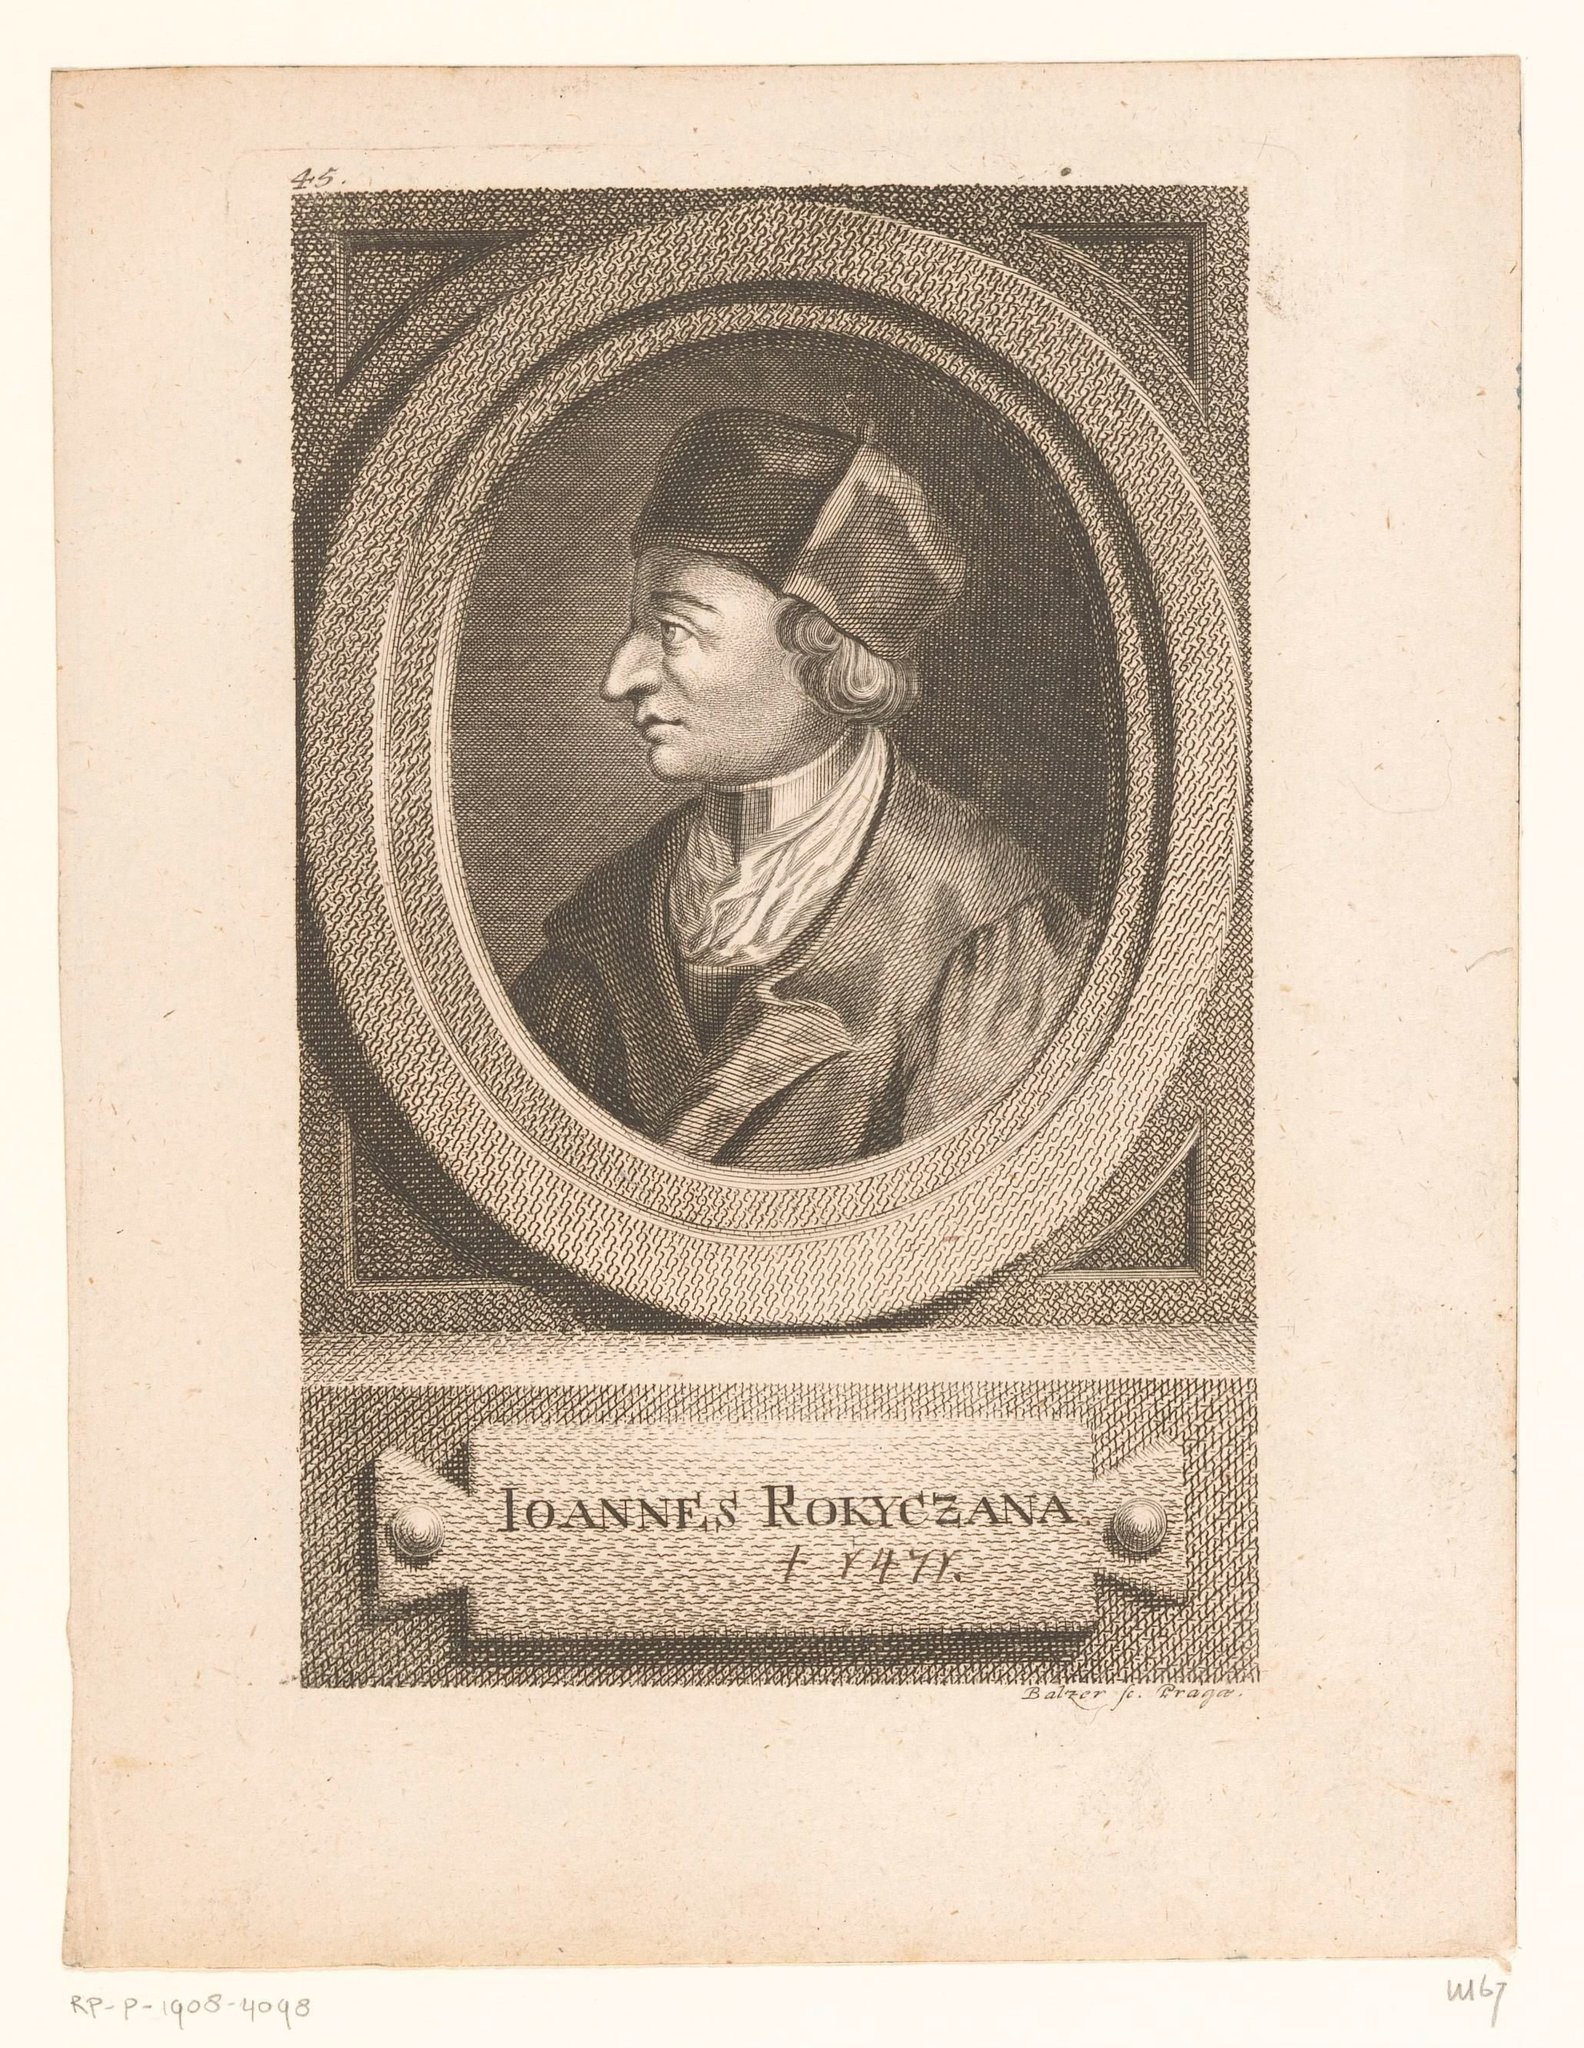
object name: print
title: Portret van Jan Rokycana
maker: jan balzer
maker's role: print maker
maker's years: 1736-1799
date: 1746-1799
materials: paper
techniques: engraving, etching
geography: prague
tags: prague, historical persons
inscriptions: collector's mark: Lugt 2228, inscription: ‘1471’